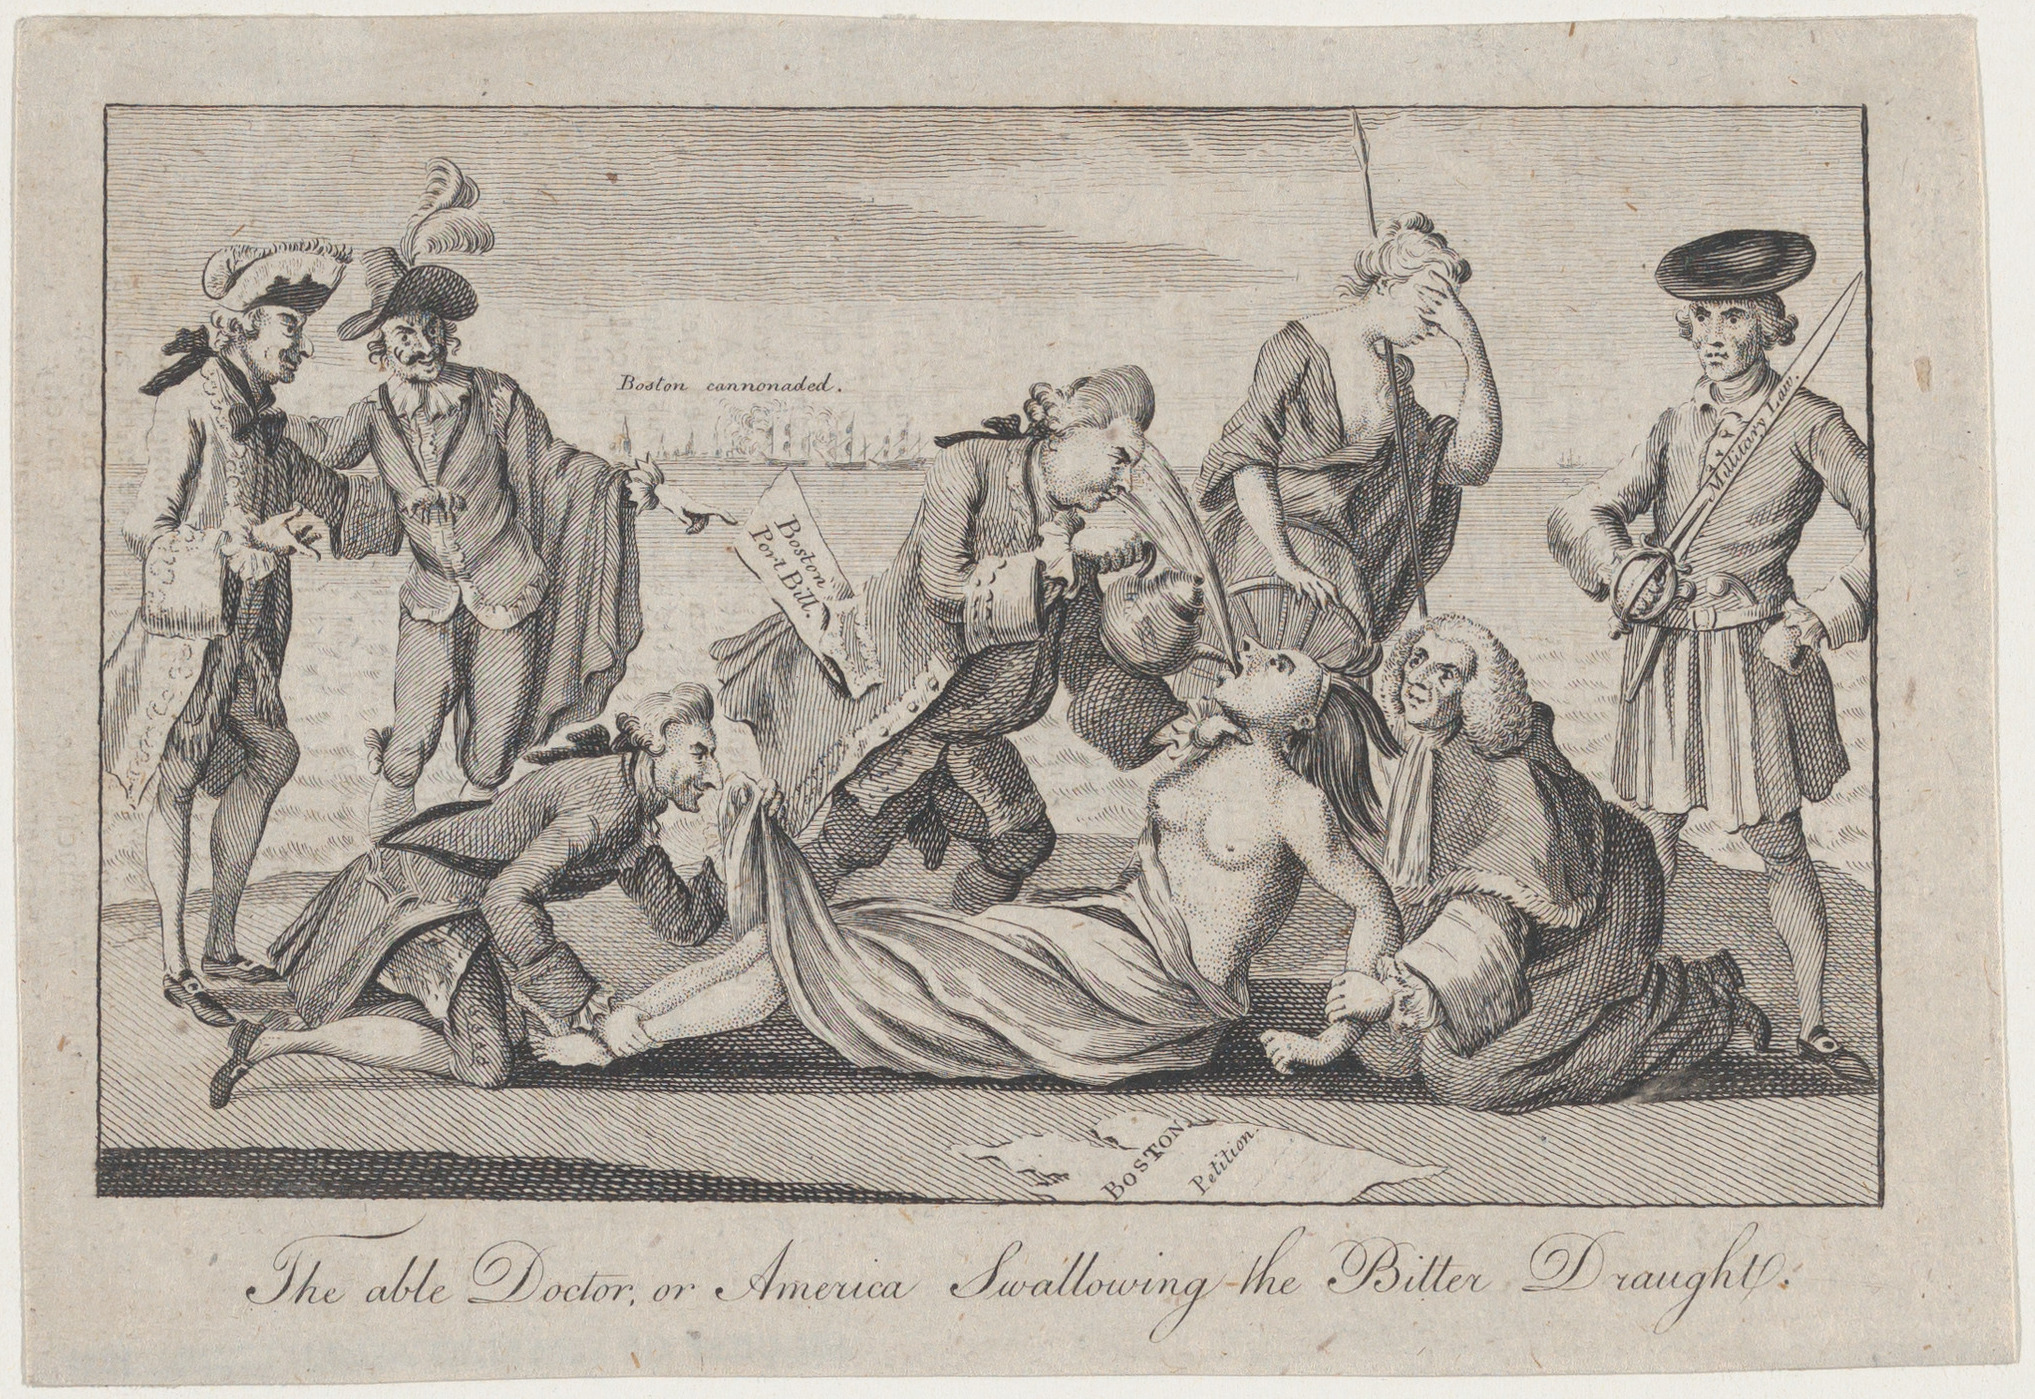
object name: print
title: The Able Doctor, or America Swallowing the Bitter Draught, from The London Magazine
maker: anonymous, british, 18th century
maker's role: artist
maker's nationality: british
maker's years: 1700-1800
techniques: engraving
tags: satire,american revolution,men,women,politics